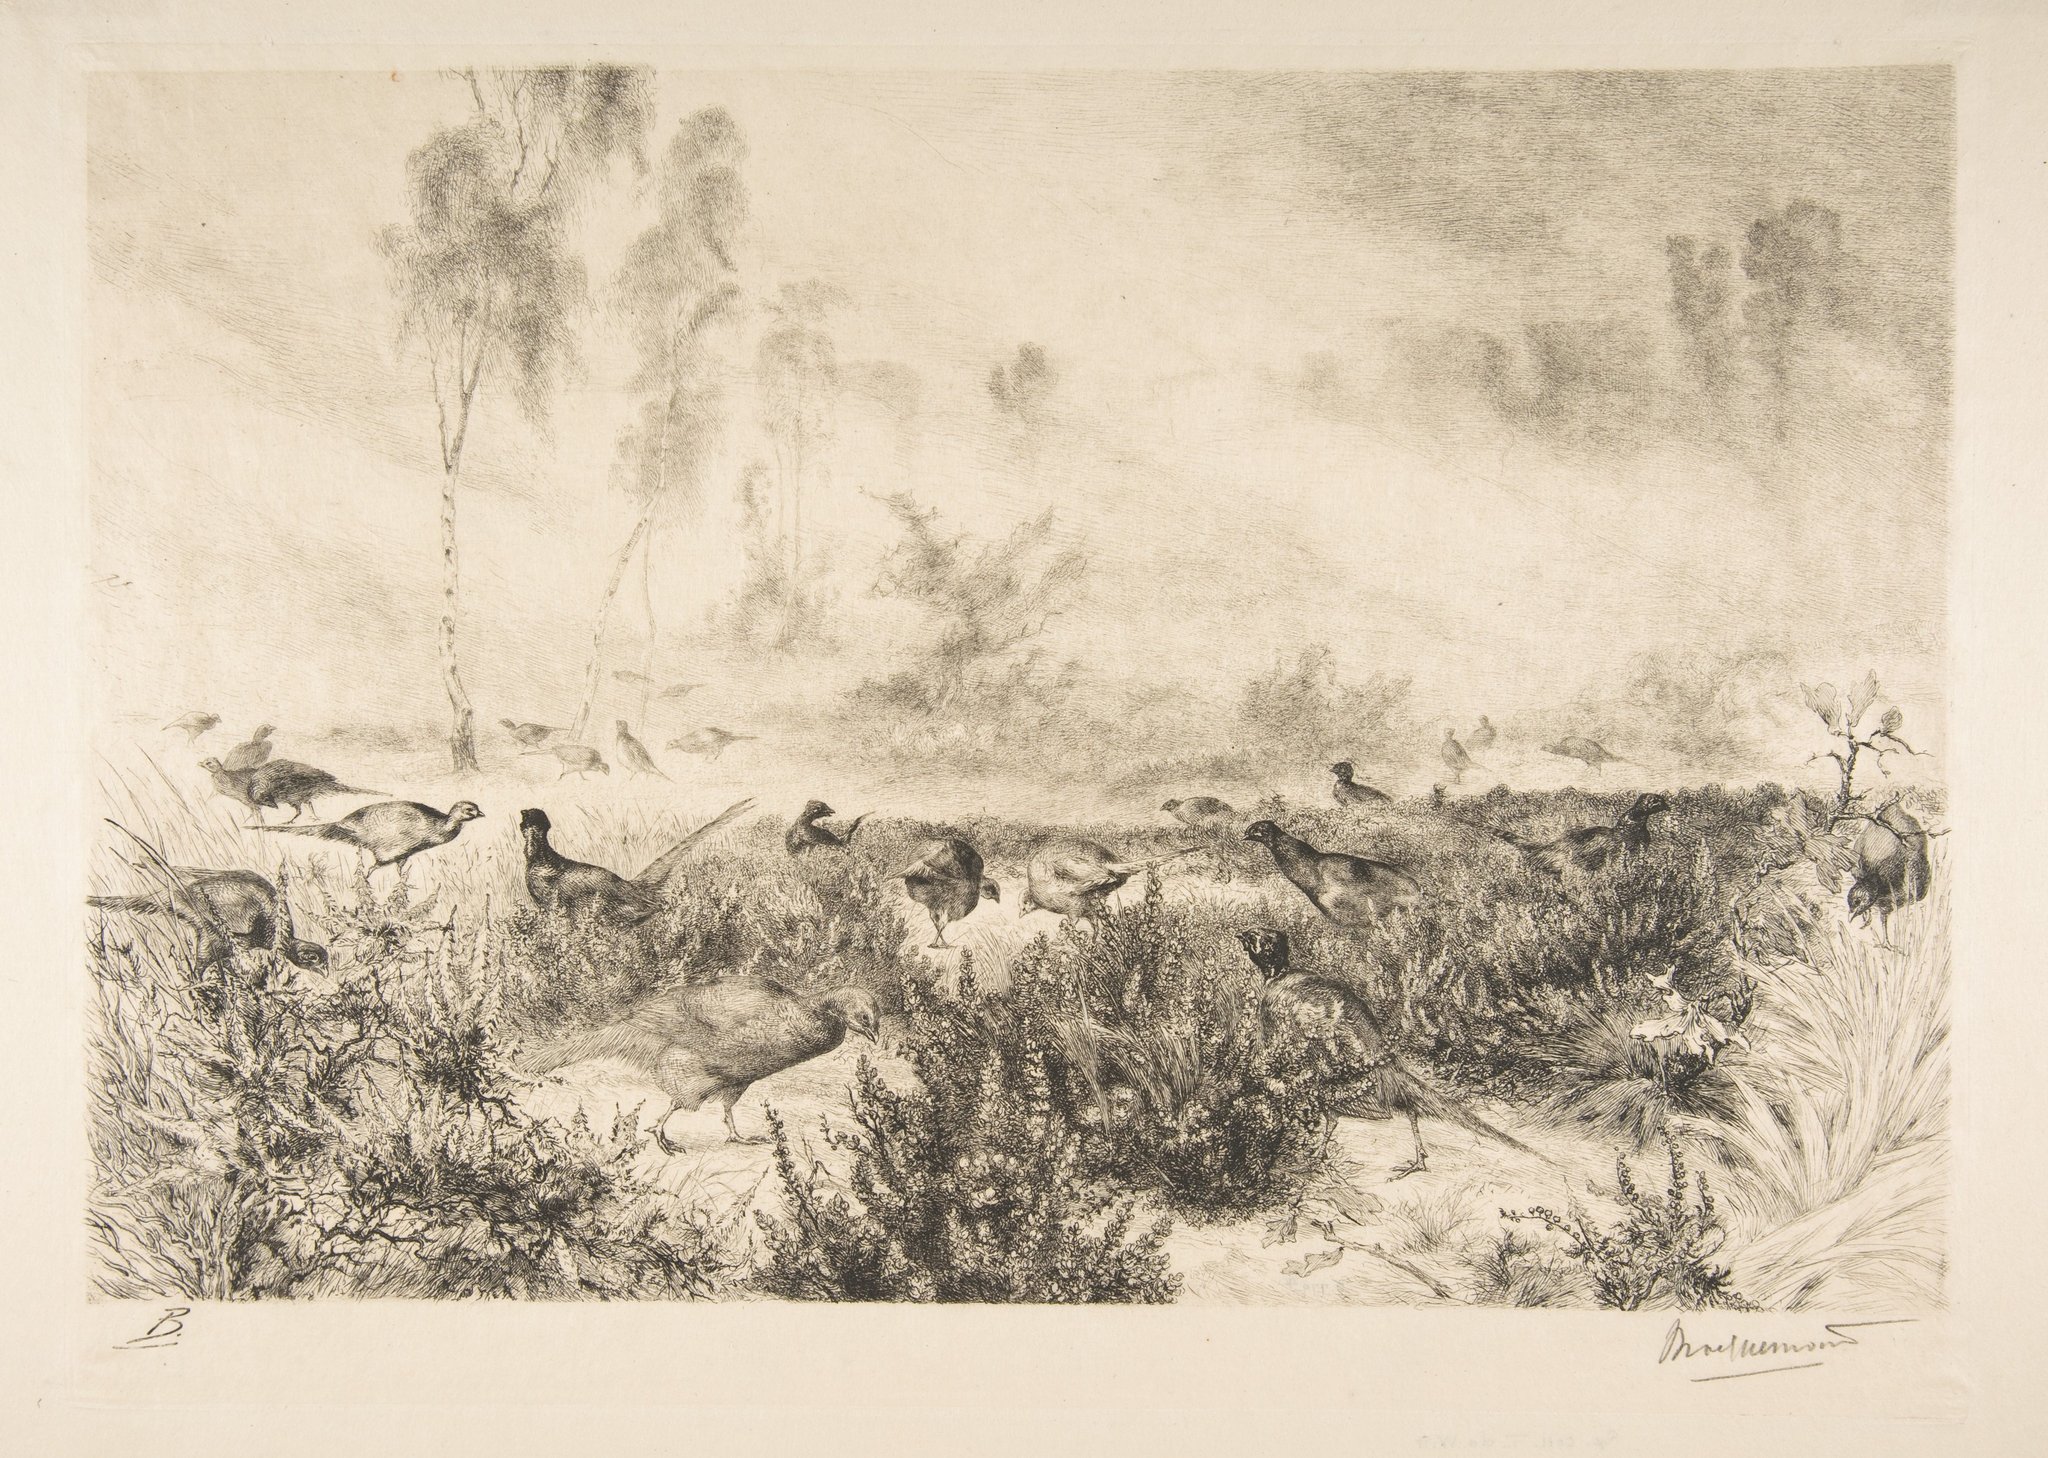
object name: print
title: Brumes du matin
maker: félix bracquemond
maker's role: artist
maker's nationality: french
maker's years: 1833-1914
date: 1882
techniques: etching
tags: birds,plants